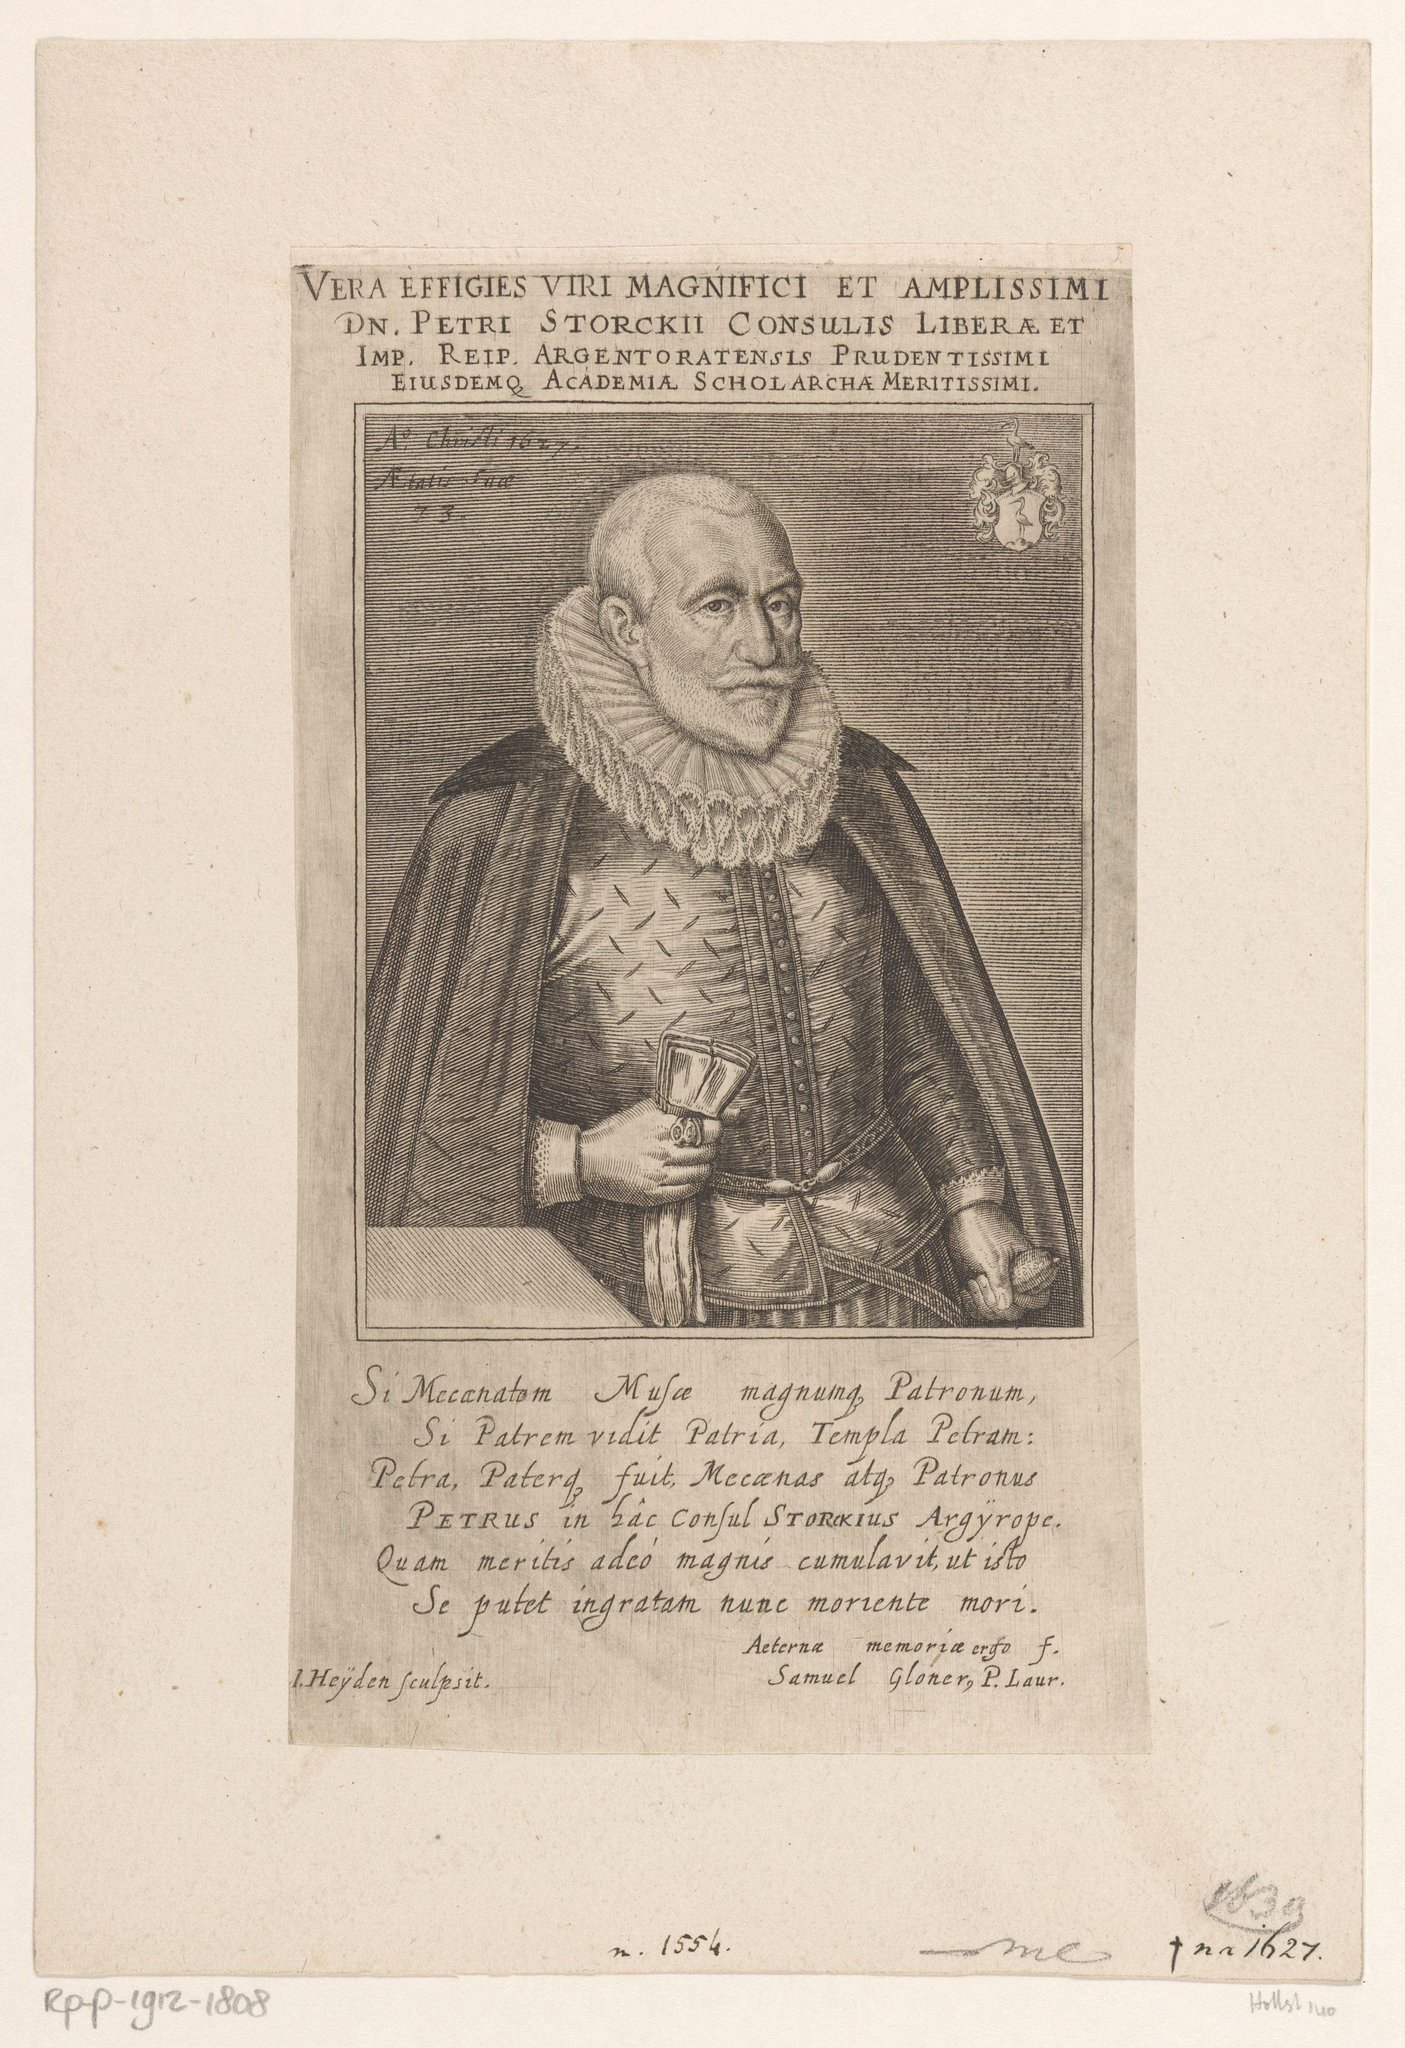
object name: print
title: Portret van Peter Storck op 73-jarige leeftijd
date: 1627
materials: paper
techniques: engraving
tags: gloves, mittens, etc., historical persons, armorial bearing, heraldry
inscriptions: collector's mark: Lugt 2228